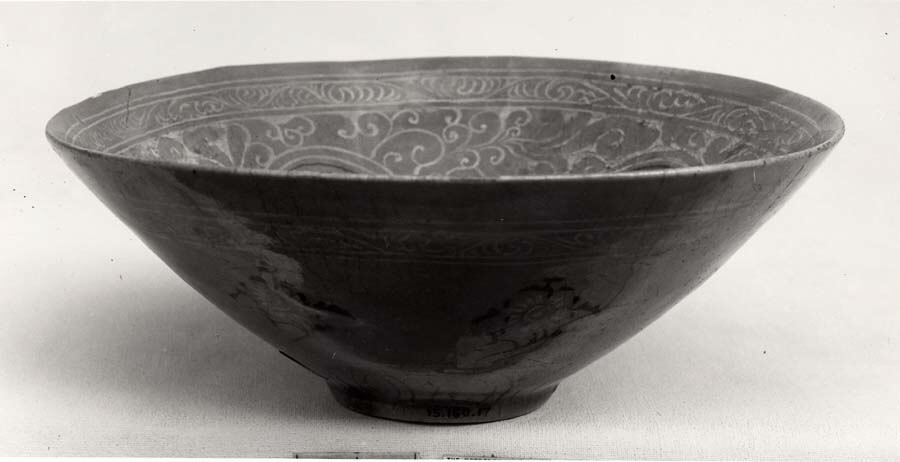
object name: bowl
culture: korean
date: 1151-1200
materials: ceramic glaze, glaze, stoneware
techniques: inlay